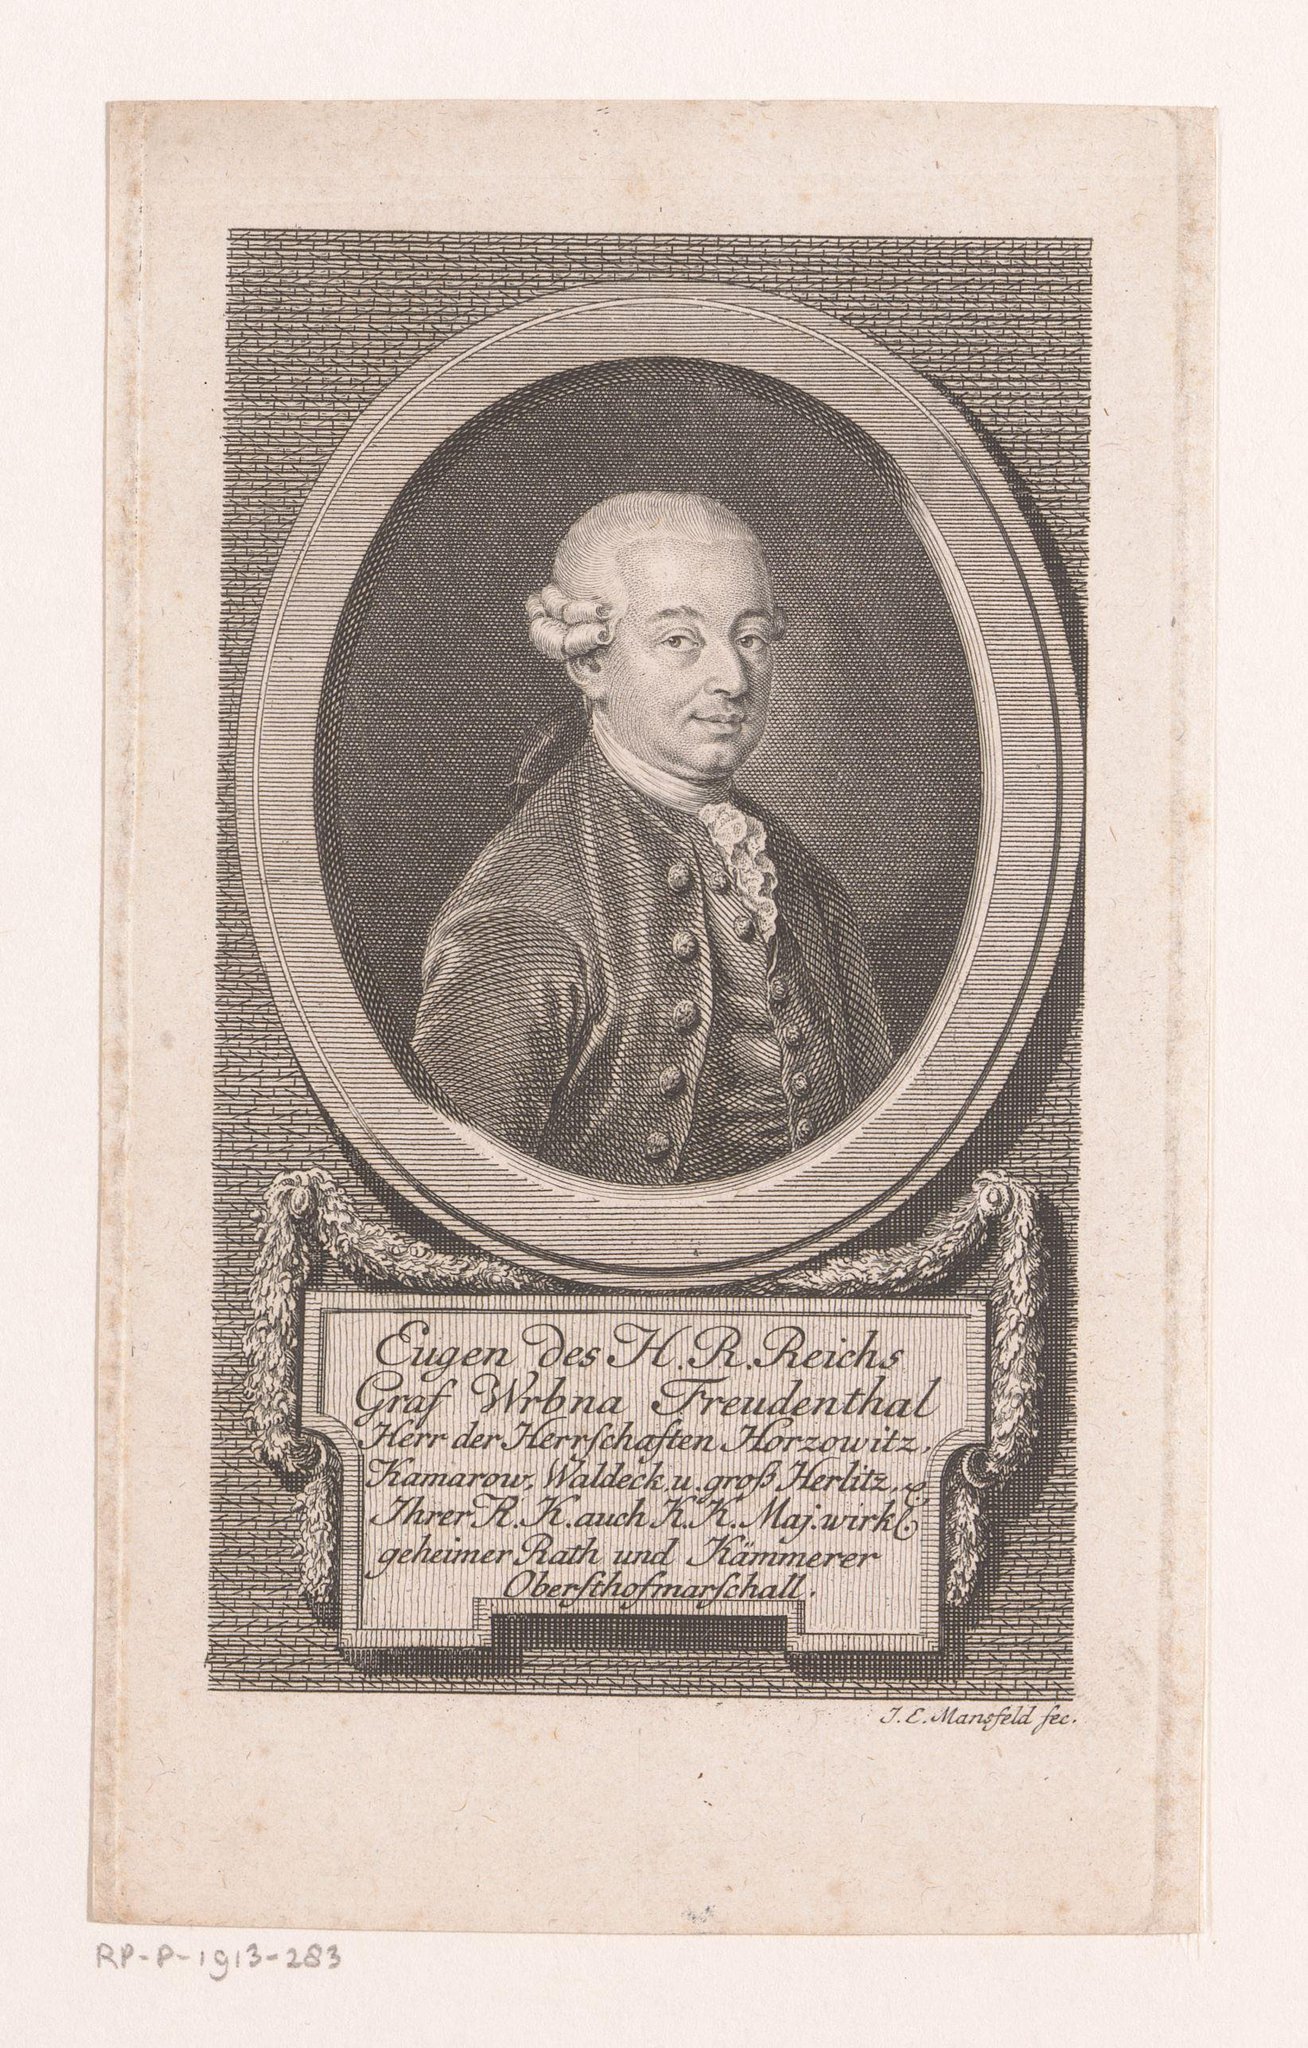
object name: print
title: Portret van Eugen Wenzel von Wrbna-Freudenthal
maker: johann ernst mansfeld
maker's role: print maker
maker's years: 1739-1796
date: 1749-1796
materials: paper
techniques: engraving, etching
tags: historical persons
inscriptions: collector's mark: Lugt 2228